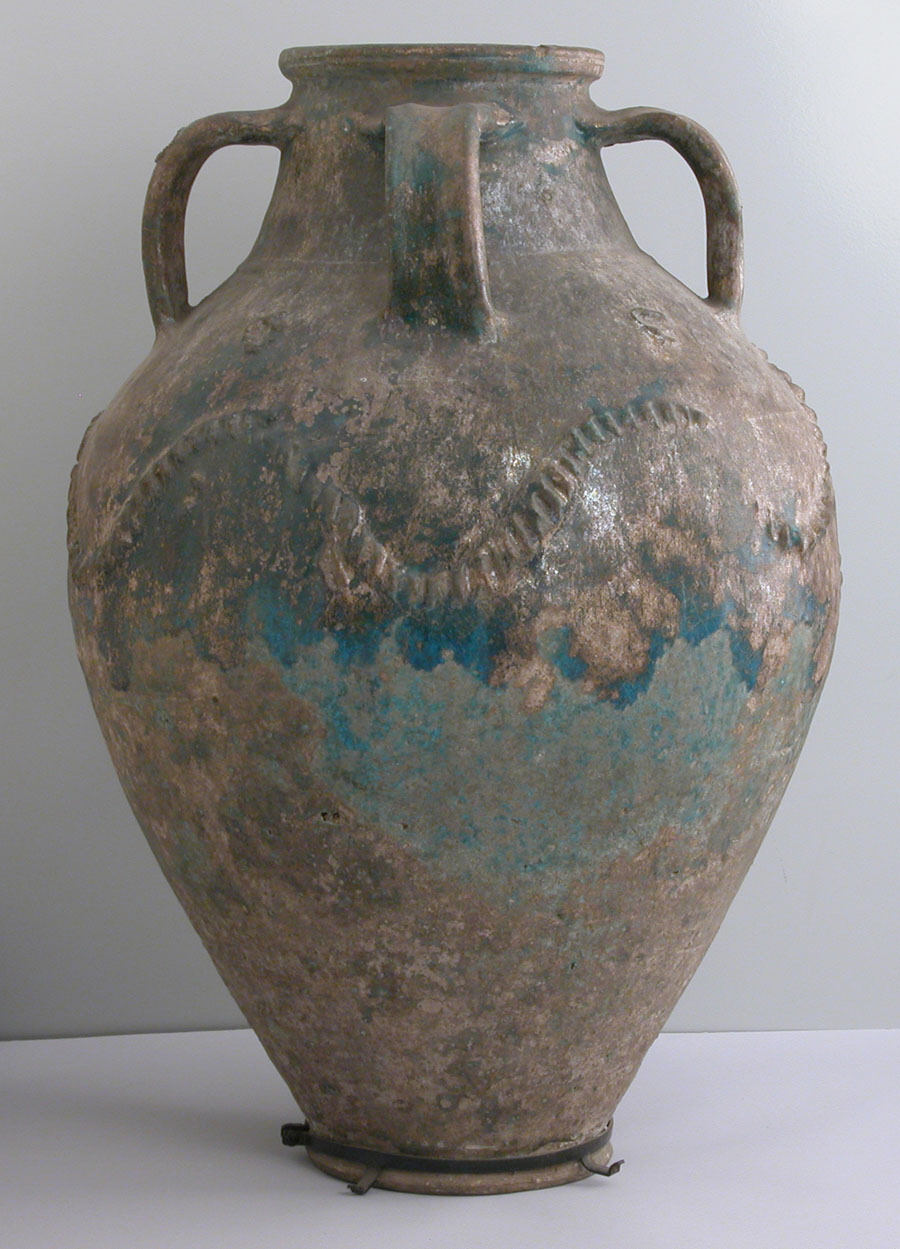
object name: jar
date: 1101-1300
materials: earthenware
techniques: glazing, molding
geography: syria